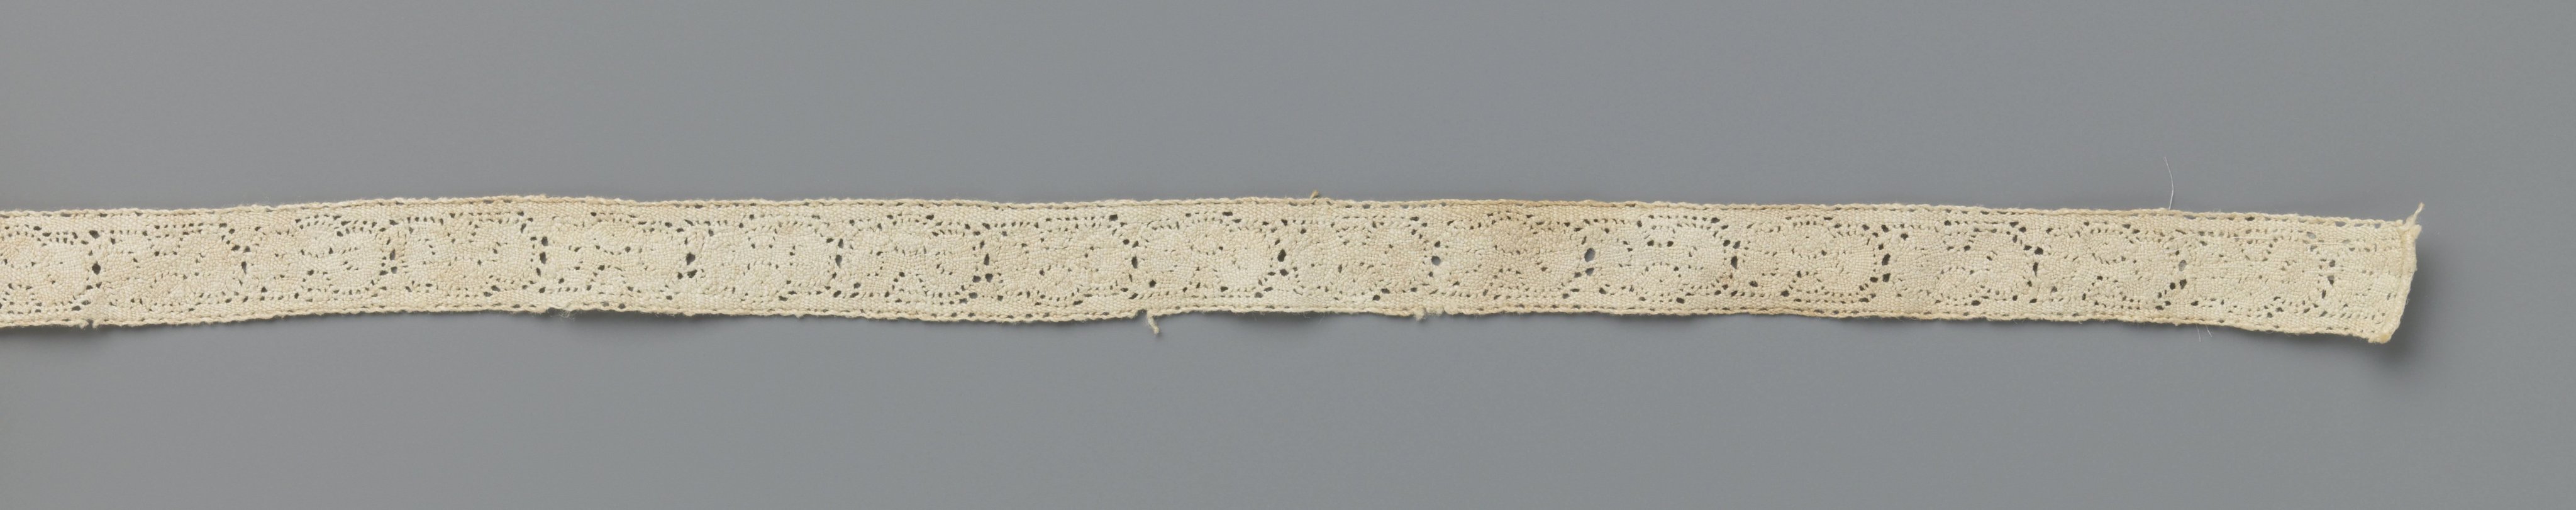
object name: strip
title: Tussenzetsel van kloskant met spitsovaaltje tussen twee ronde vormen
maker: Anonymous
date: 1640-1660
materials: linen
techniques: lace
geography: antwerp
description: Tussenzetsel van naturelkleurige Hollandse kloskant. Met kleine uitsparingen is een zich herhalend patroon te onderscheiden van een spitsovaaltje die afwisselend boven- of onderaan tussen twee iets grotere ronde vormen is geklemd. Er is nauwelijks sprake van een grond. De motieven zijn gemaakt in linnenslag met opengewerkte randjes. Boven- en onderzijde zijn recht afgewerkt.